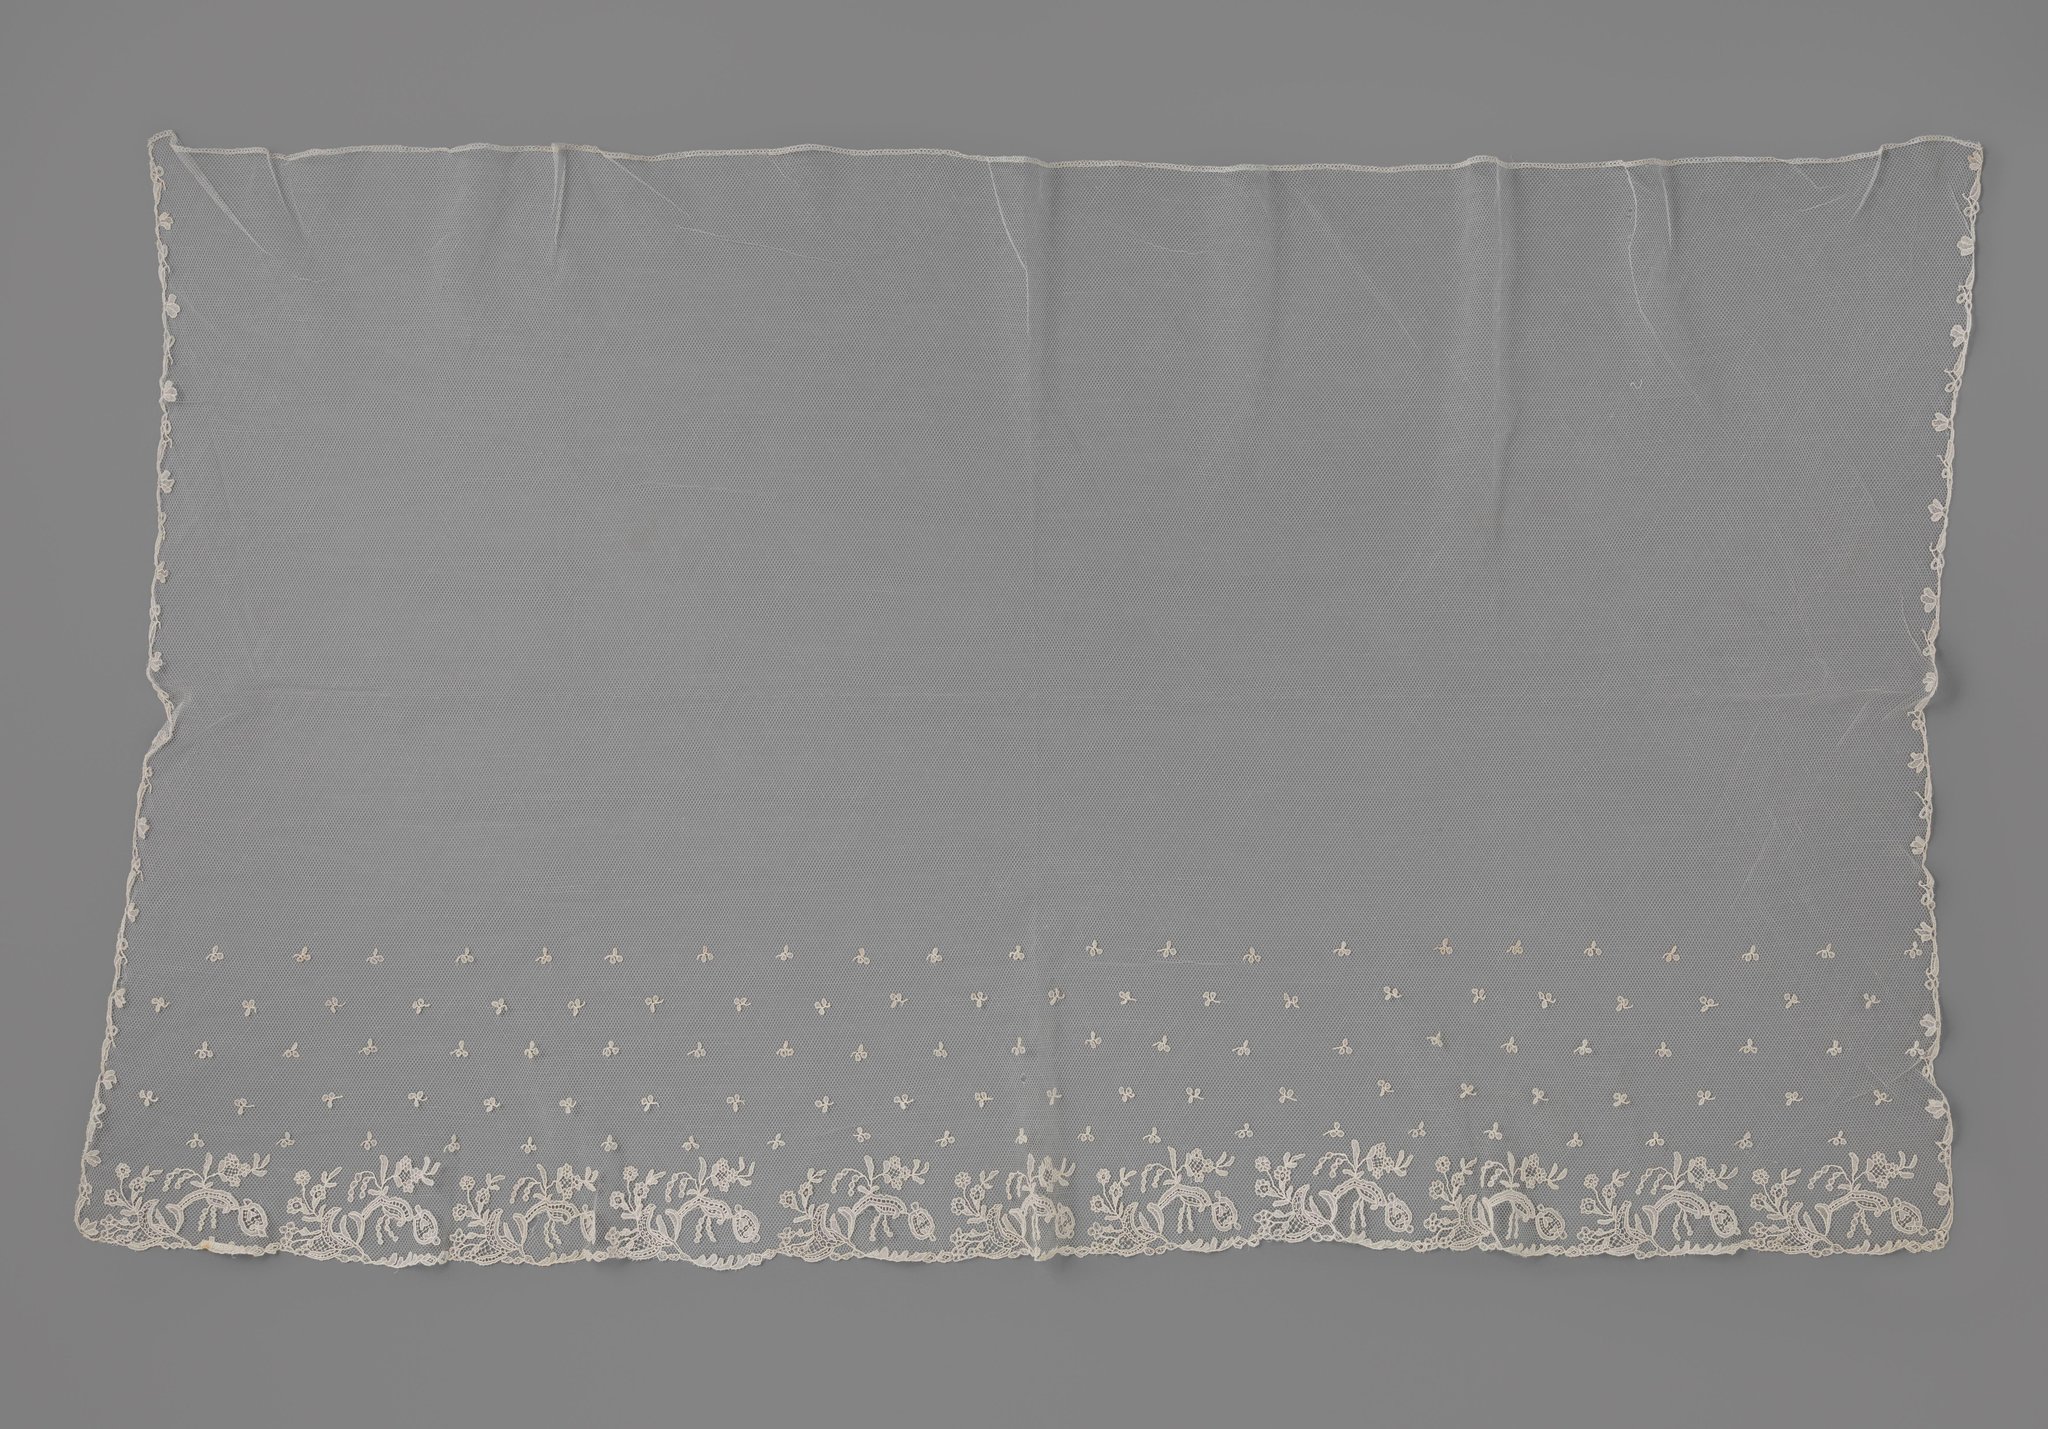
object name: hat veil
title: Hoedensluier van machinale tule met applicatiekant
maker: Anonymous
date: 1840-1850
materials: lace, fiber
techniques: lace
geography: western europe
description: Hoedensluier, wit, van machinale tule met applicatiekant langs drie licht geschulpte zijden. De decoratie bestaat uit bloemen, bloemtakken en granaatappels.